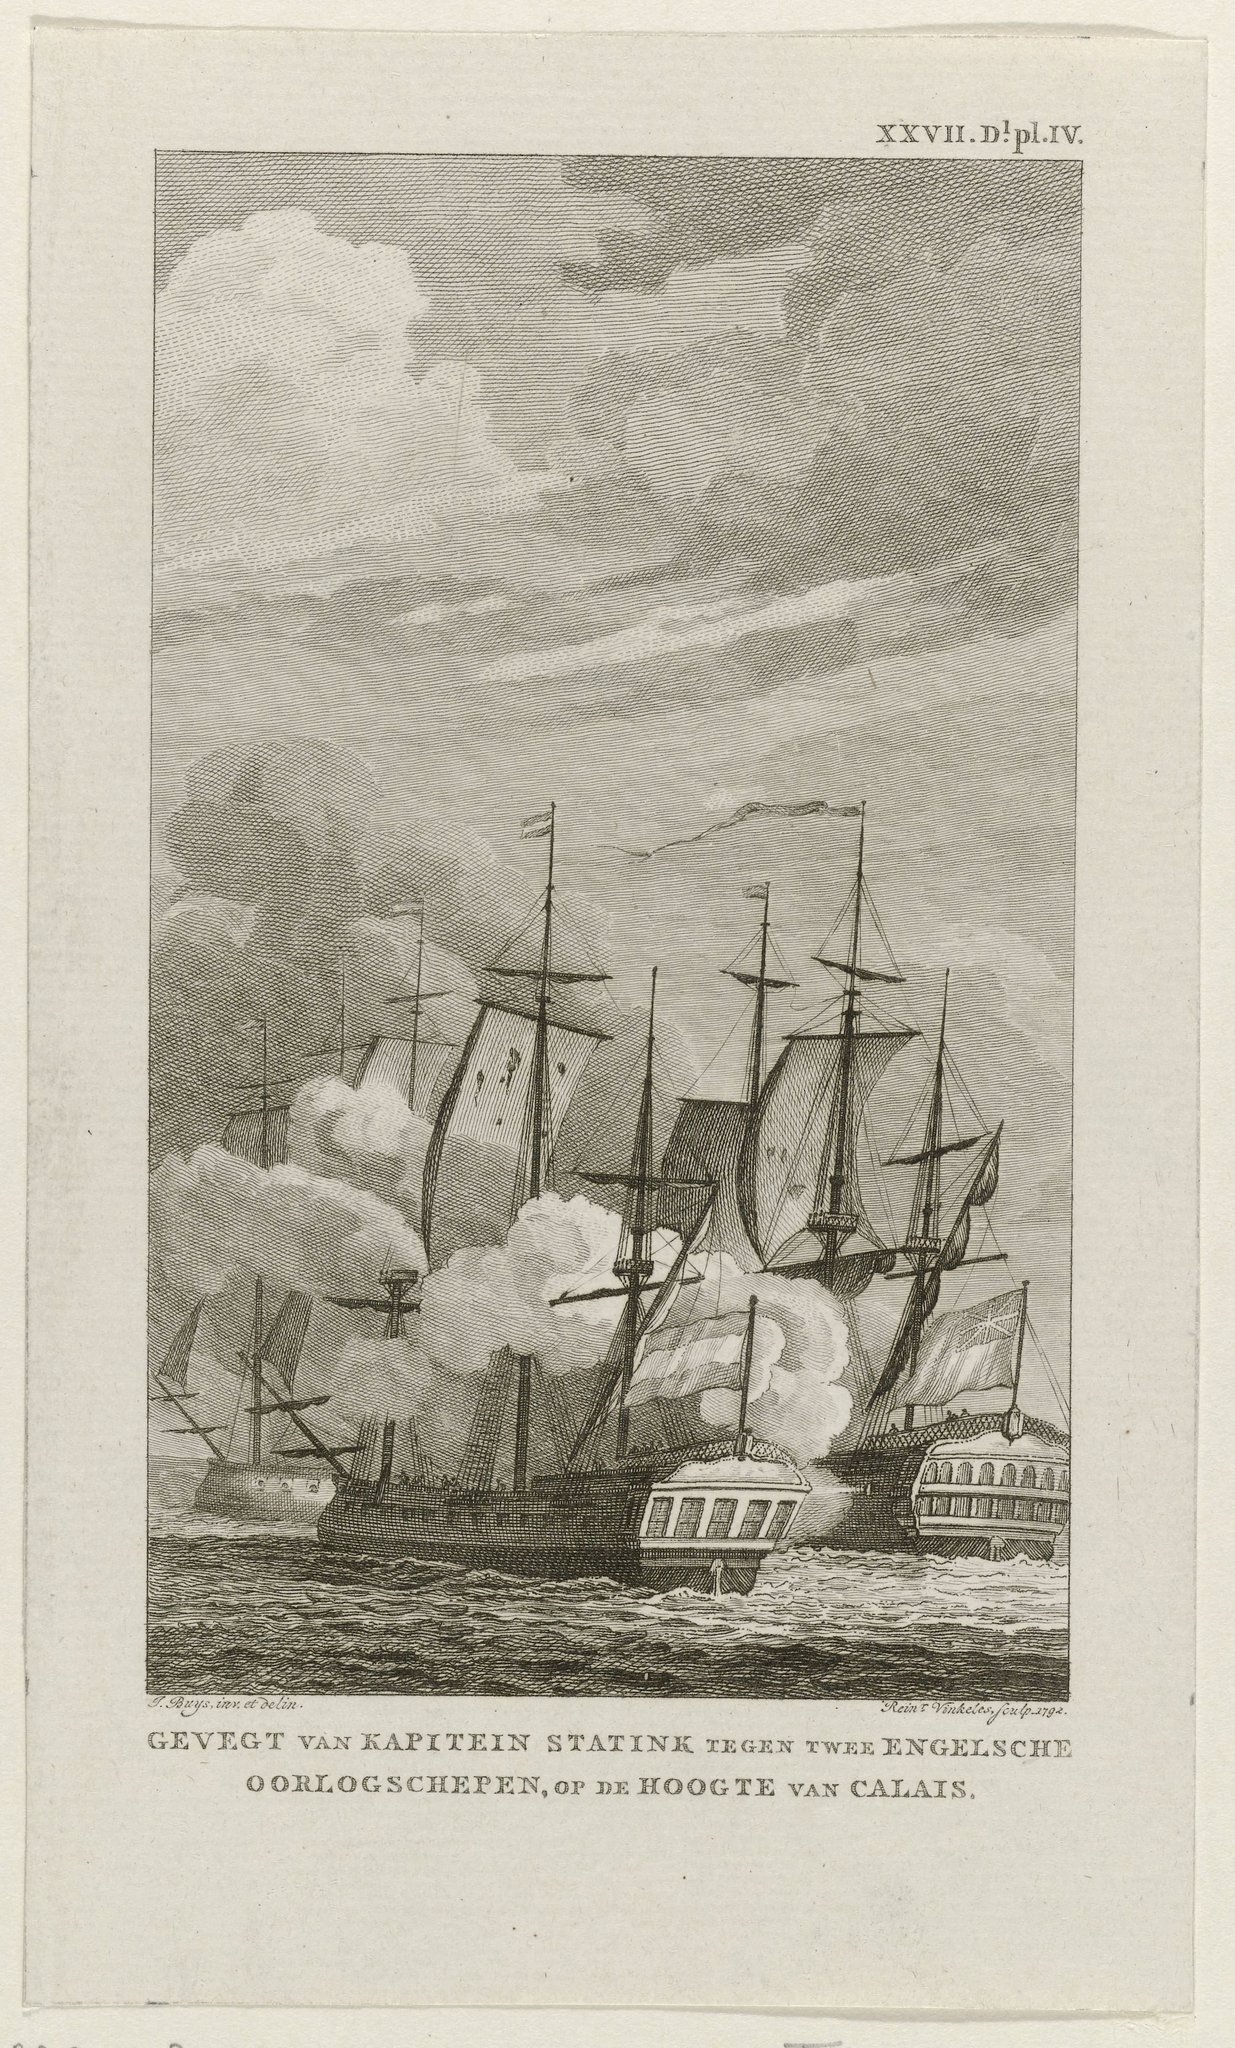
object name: print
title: Kapitein Statink bij Calais in gevecht met twee Engelse oorlogsschepen, 1780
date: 1792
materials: paper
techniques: engraving, etching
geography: northern netherlands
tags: battle (+ naval force), english channel, fourth anglo-dutch war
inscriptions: collector's mark: Lugt 2228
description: Het schip de Prinses Carolina onder bevel van kapitein Statink wordt in het Kanaal bij Calais aangevallen en opgebracht door twee Engelse oorlogsschepen, 25 december 1780. Gemerkt rechtsboven: XXVII.Dl.pl.IV.